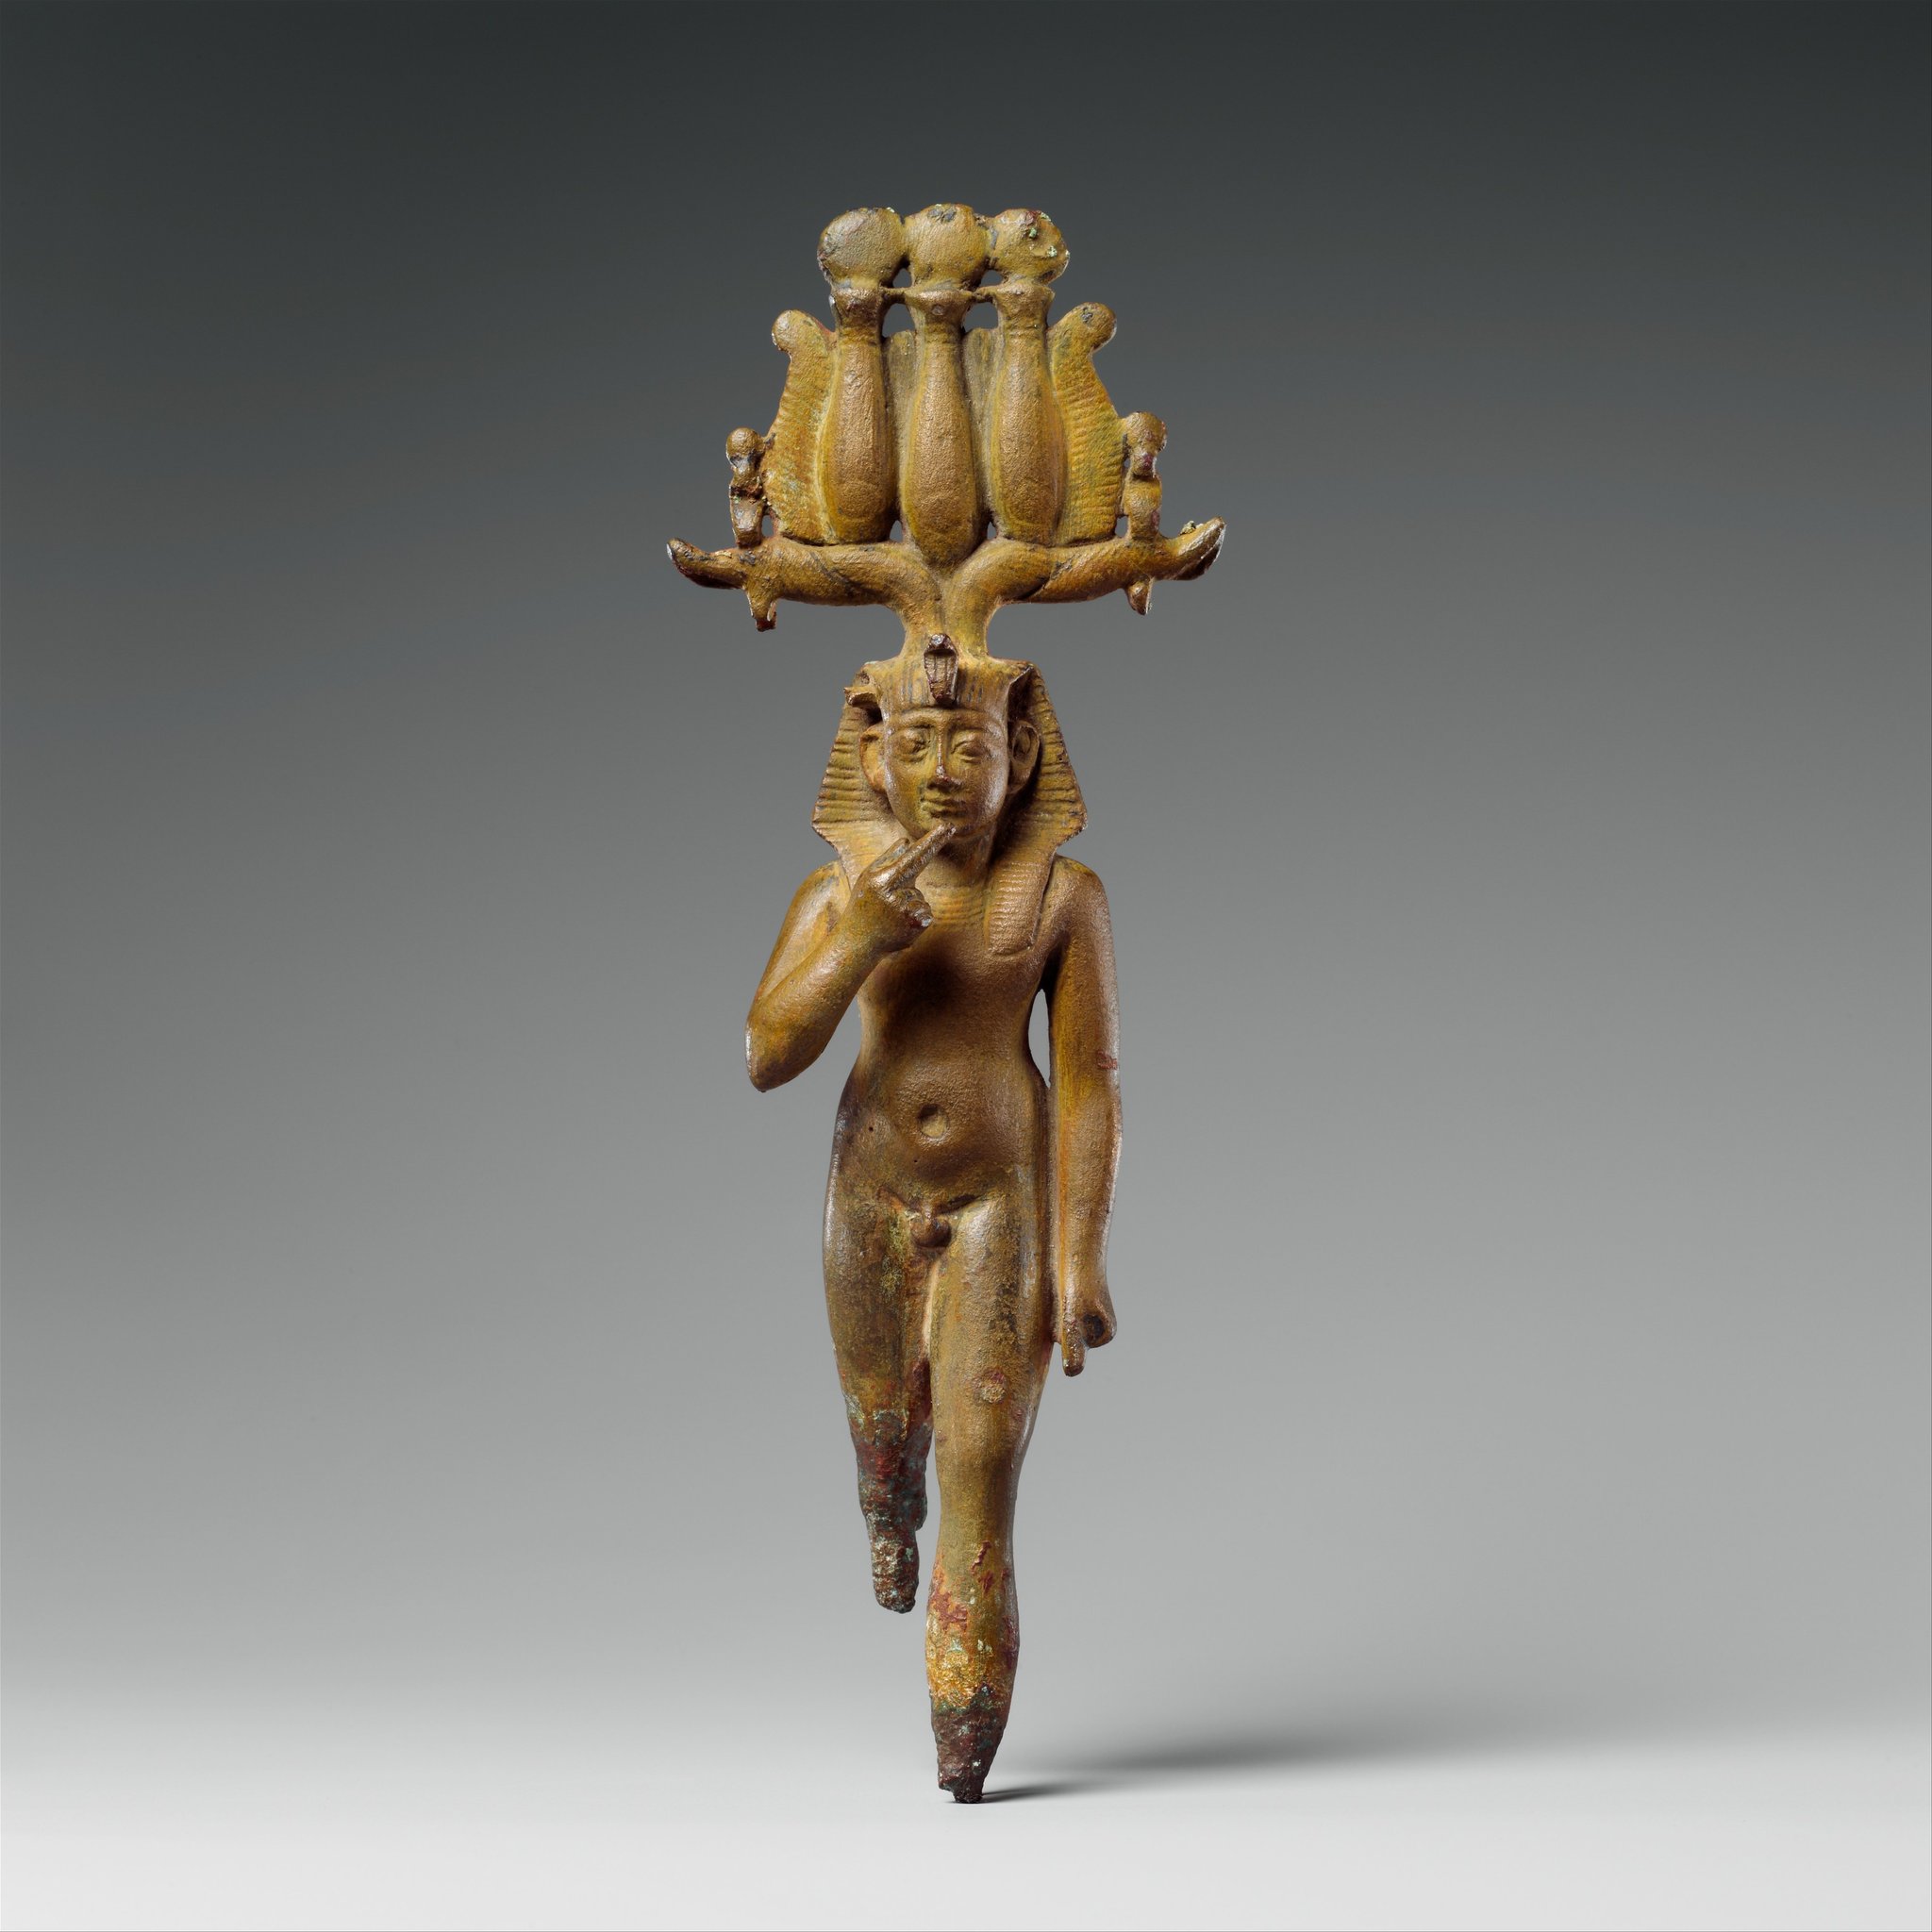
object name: statuette, harpokrates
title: A child god, probably Harpokrates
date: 1-100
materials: bronze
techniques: gilding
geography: egypt